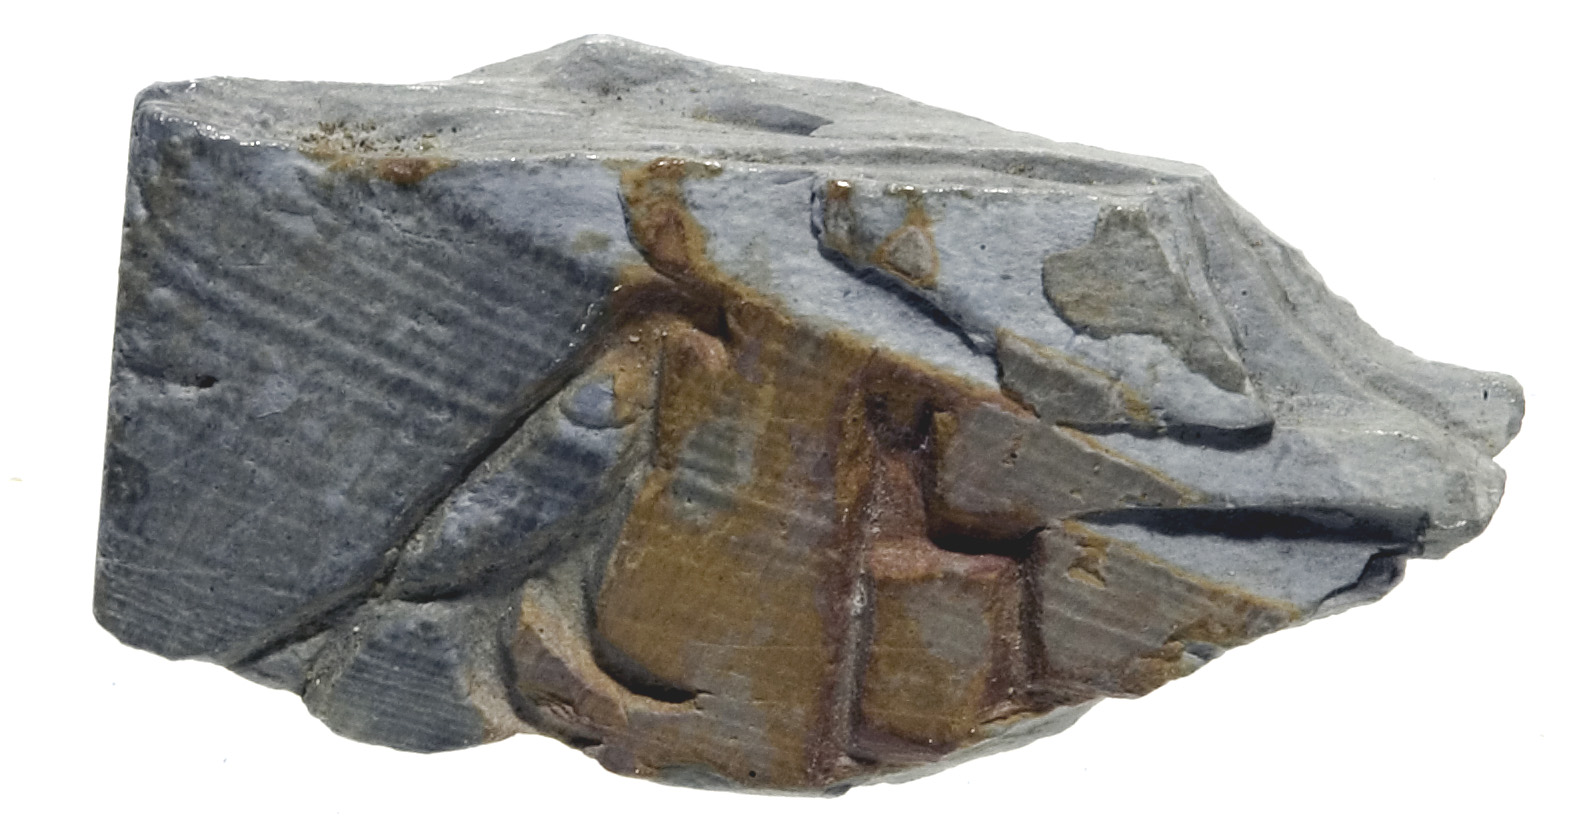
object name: ivory tag, den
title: Fragment of an ivory tag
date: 3013-2999 BCE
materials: ivory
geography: egypt